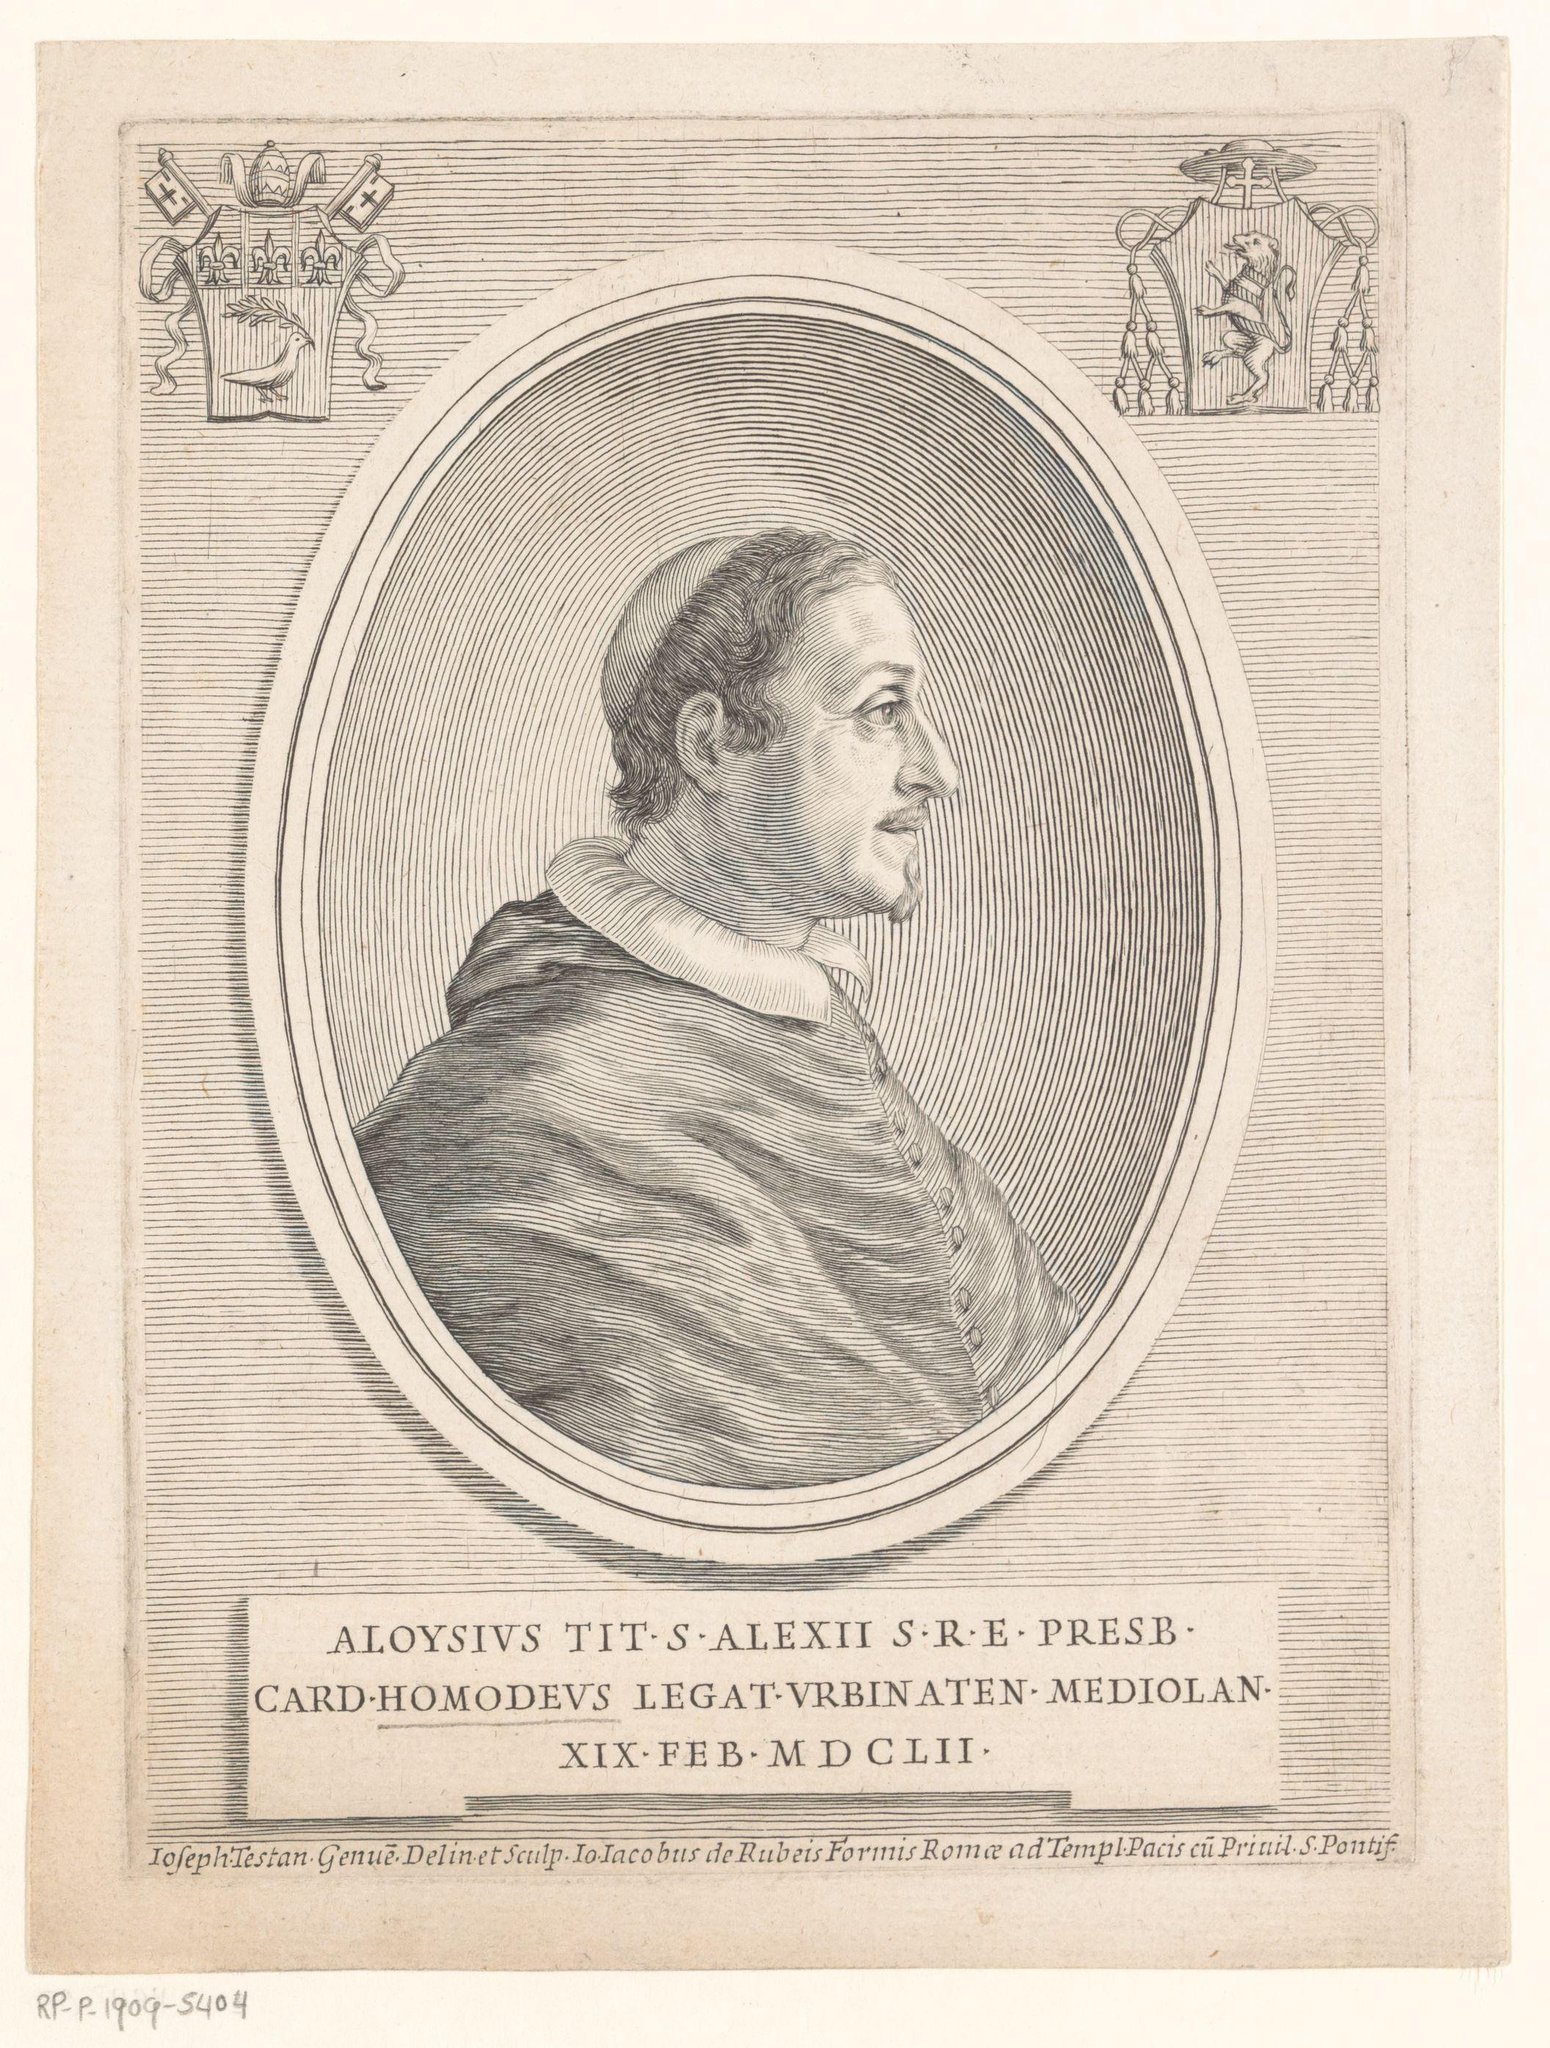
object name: print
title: Portret van kardinaal Luigi Omodei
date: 1658-1679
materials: paper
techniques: engraving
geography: vatican city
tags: rome, cardinal, historical persons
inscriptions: collector's mark: Lugt 2228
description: Prent uit een reeks van onbekende omvang met portretten van kardinalen. De prenten werden vanaf 1657 vervaardigd in opdracht van uitgever Giovanni Giacomo de’ Rossi, waarna de productie werd voortgezet onder leiding van zijn opvolgers Domenico de’ Rossi en Lorenzo Filippo de’ Rossi, en ten slotte onder leiding van de Calcographia R.C.A.